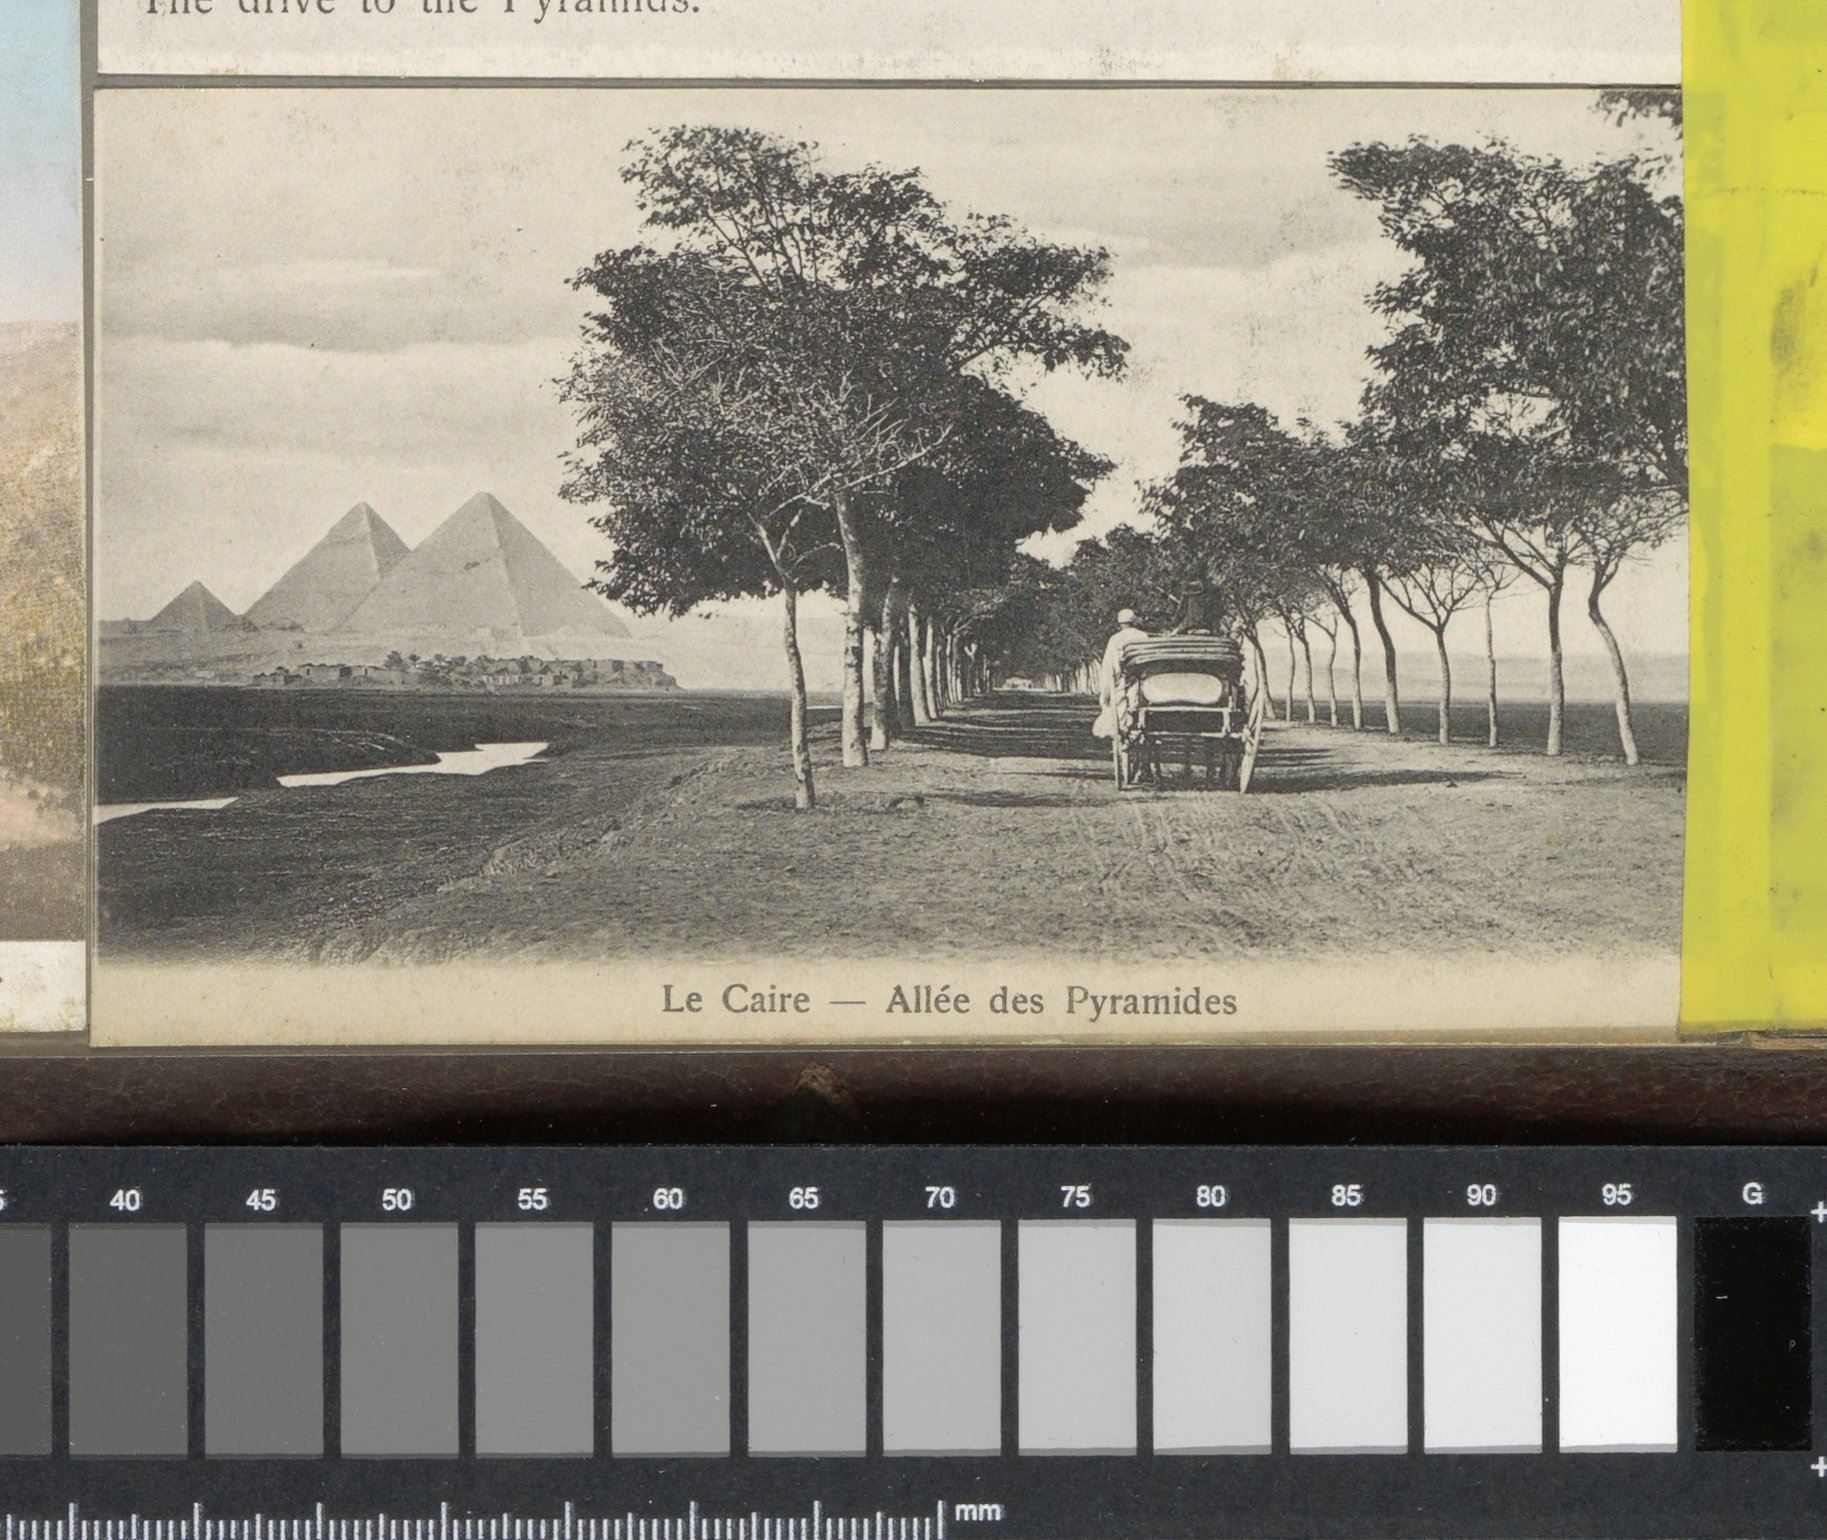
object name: ansichtkaart, prentbriefkaart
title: Le Caire - Allée des Pyramides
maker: Anonymous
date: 1895-1905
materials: paper, photographic support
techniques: photograph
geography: gizeh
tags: pyramid (historical grave form), lane, alley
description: Onderdeel van Reisalbum met foto's van bezienswaardigheden in Griekenland en Egypte.